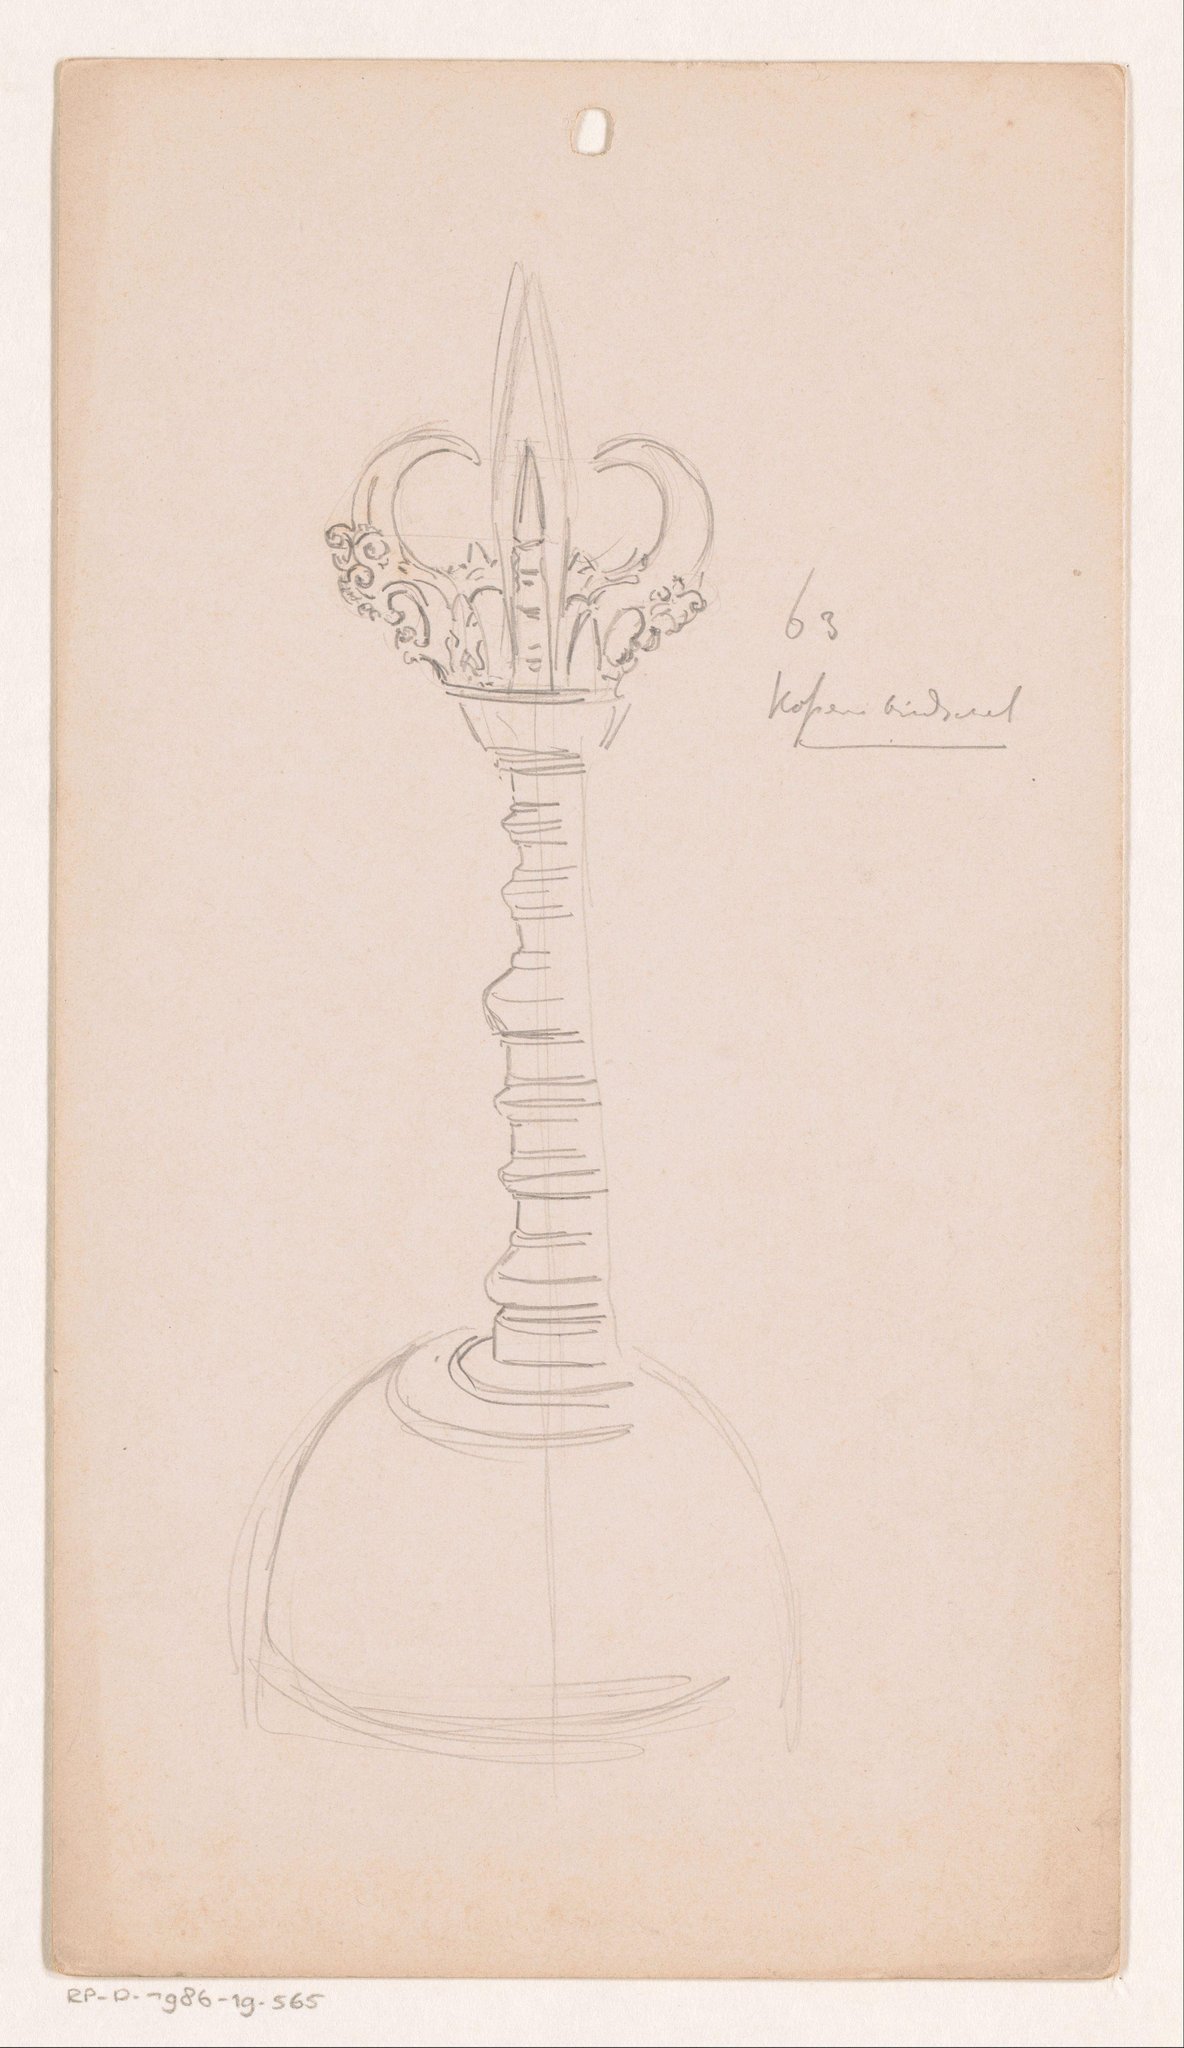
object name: drawing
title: Langwerpig voorwerp versierd met hoorns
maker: reinier willem petrus de vries (1874-1953)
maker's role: draughtsman, print maker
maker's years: 1874-1953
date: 1884-1952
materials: paper, pencil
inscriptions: annotation: ‘63/ koper [...]el’, inscription: ‘No 3006./ ROYAL BRISTOL. 50 bij 65 ctm. 60 KILO’, collector's mark: ‘R:MVS.’